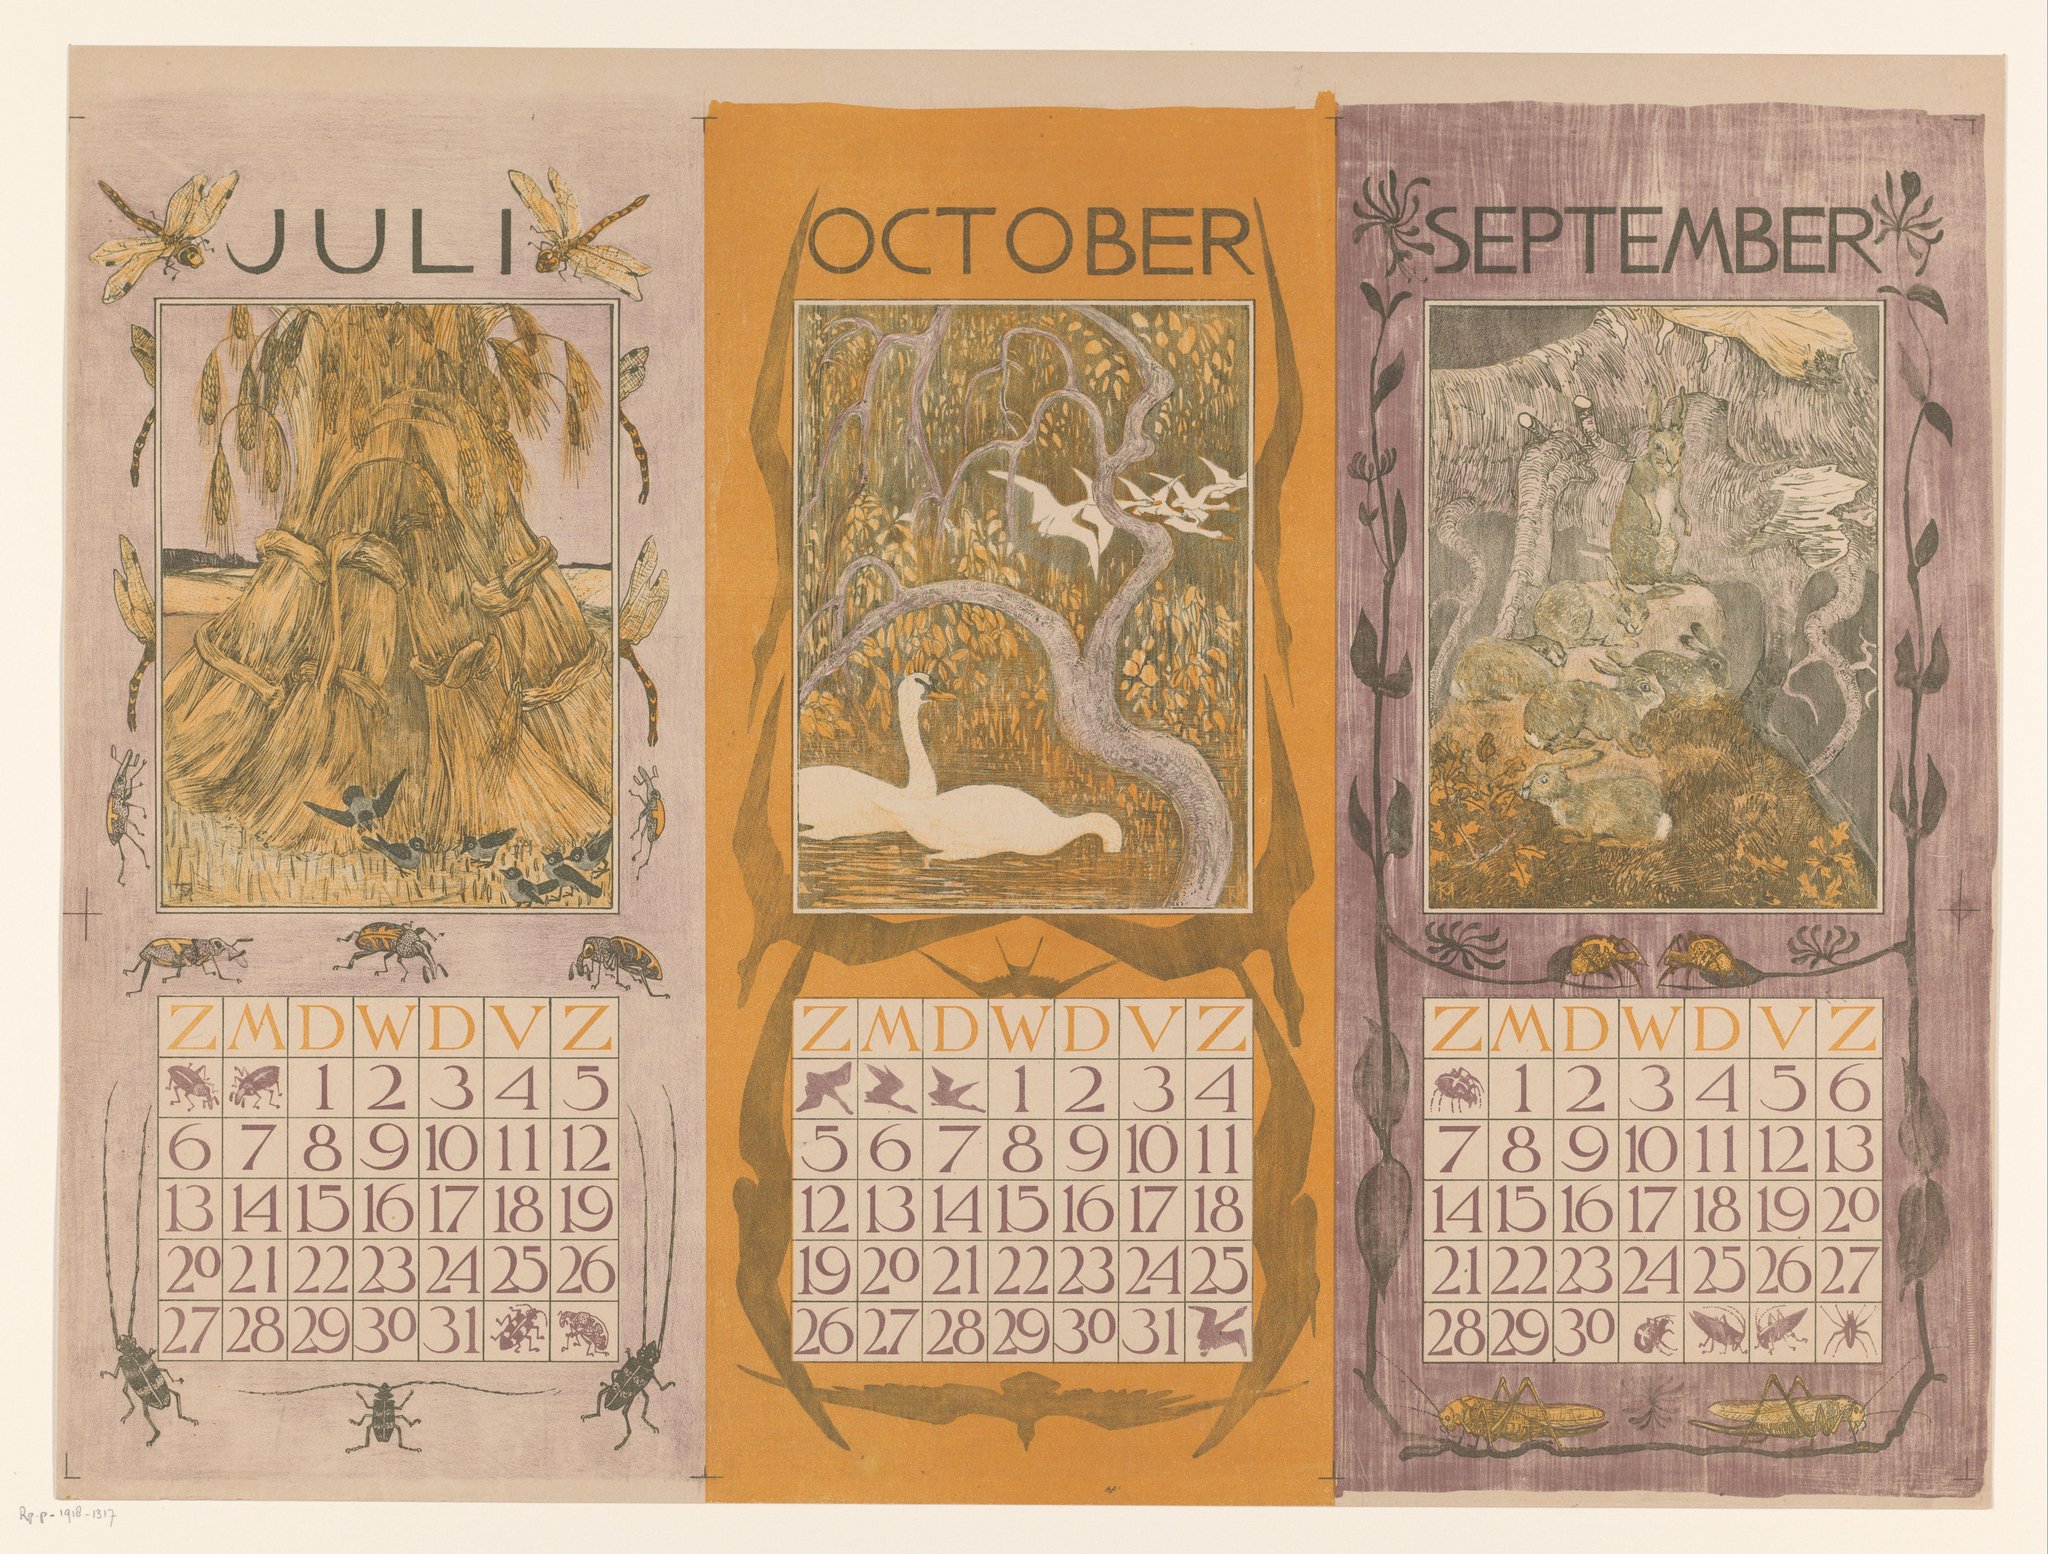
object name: calendar leaf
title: Kalenderbladen van juli, oktober en september, met korenschoven, zwanen en konijnen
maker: theo van hoytema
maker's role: draughtsman, painter, print maker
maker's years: 1863-1917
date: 1901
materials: paper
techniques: lithograph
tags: plants and herbs: wheat, calendar, almanac, water-birds: swan, rodents: rabbit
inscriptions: collector's mark: Lugt 2233